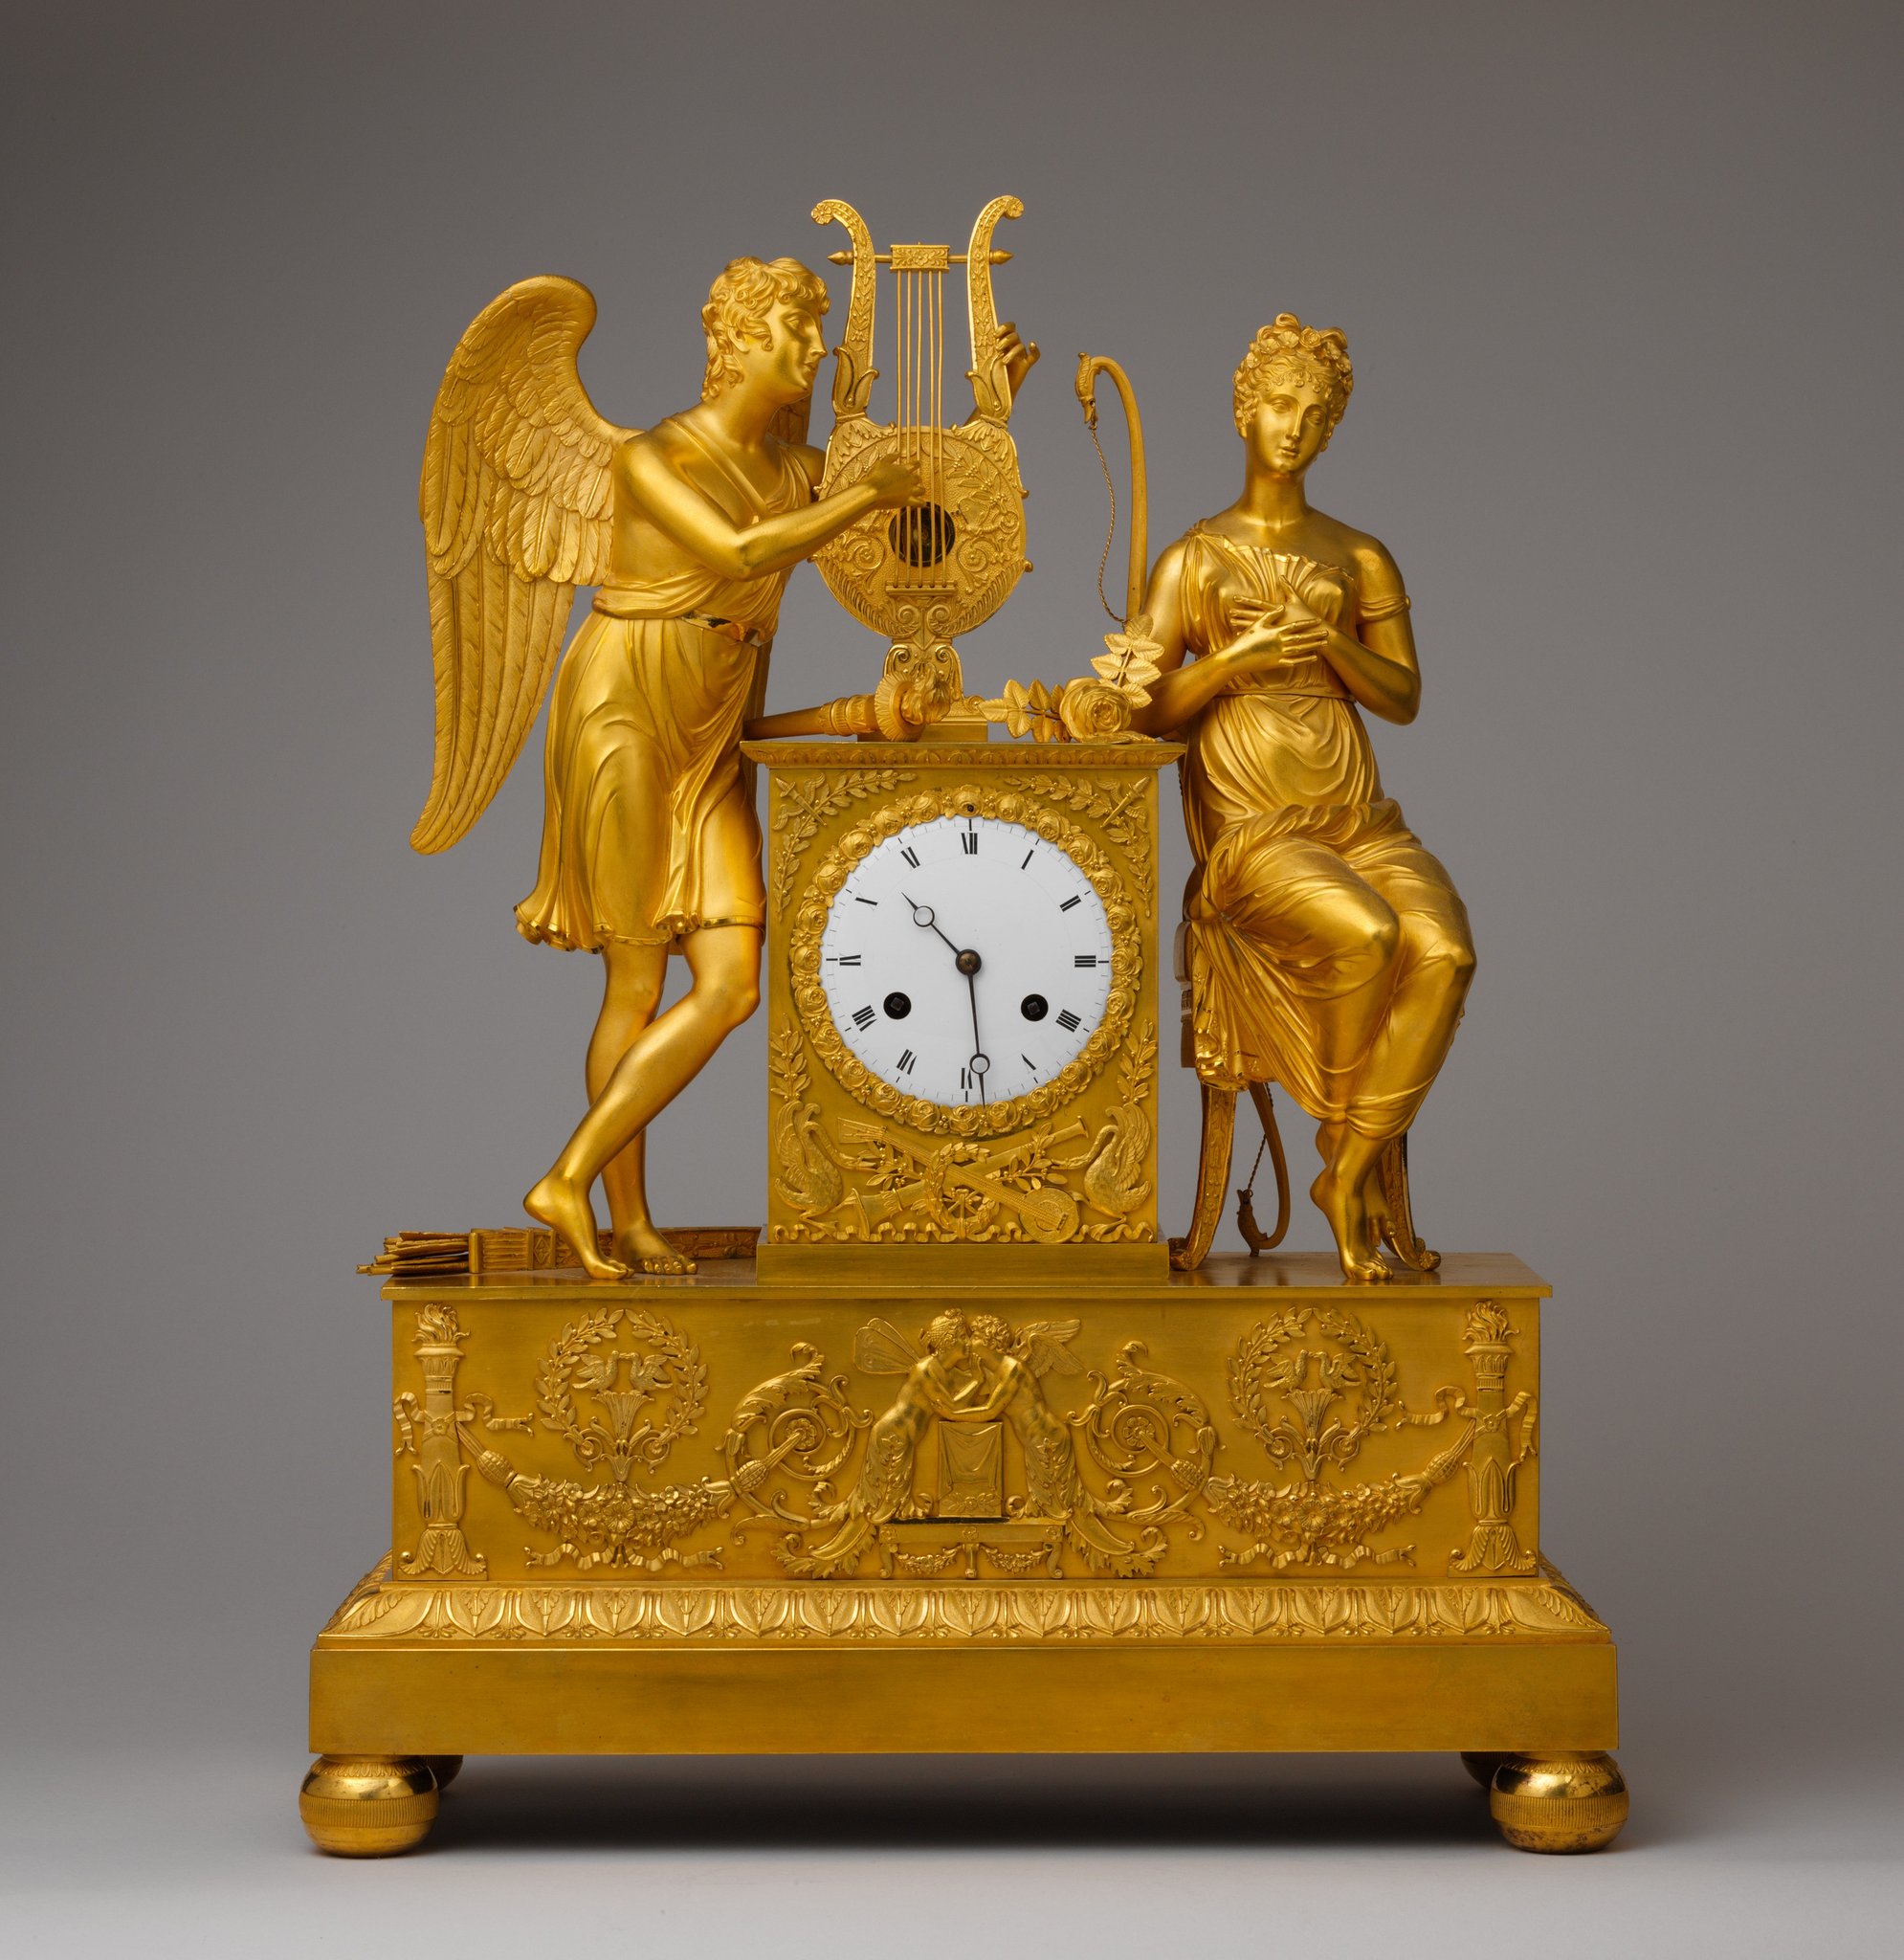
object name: mantel clock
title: Love and Innocence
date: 1820-1825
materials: enamel, gilt bronze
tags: women,cupid,lyres